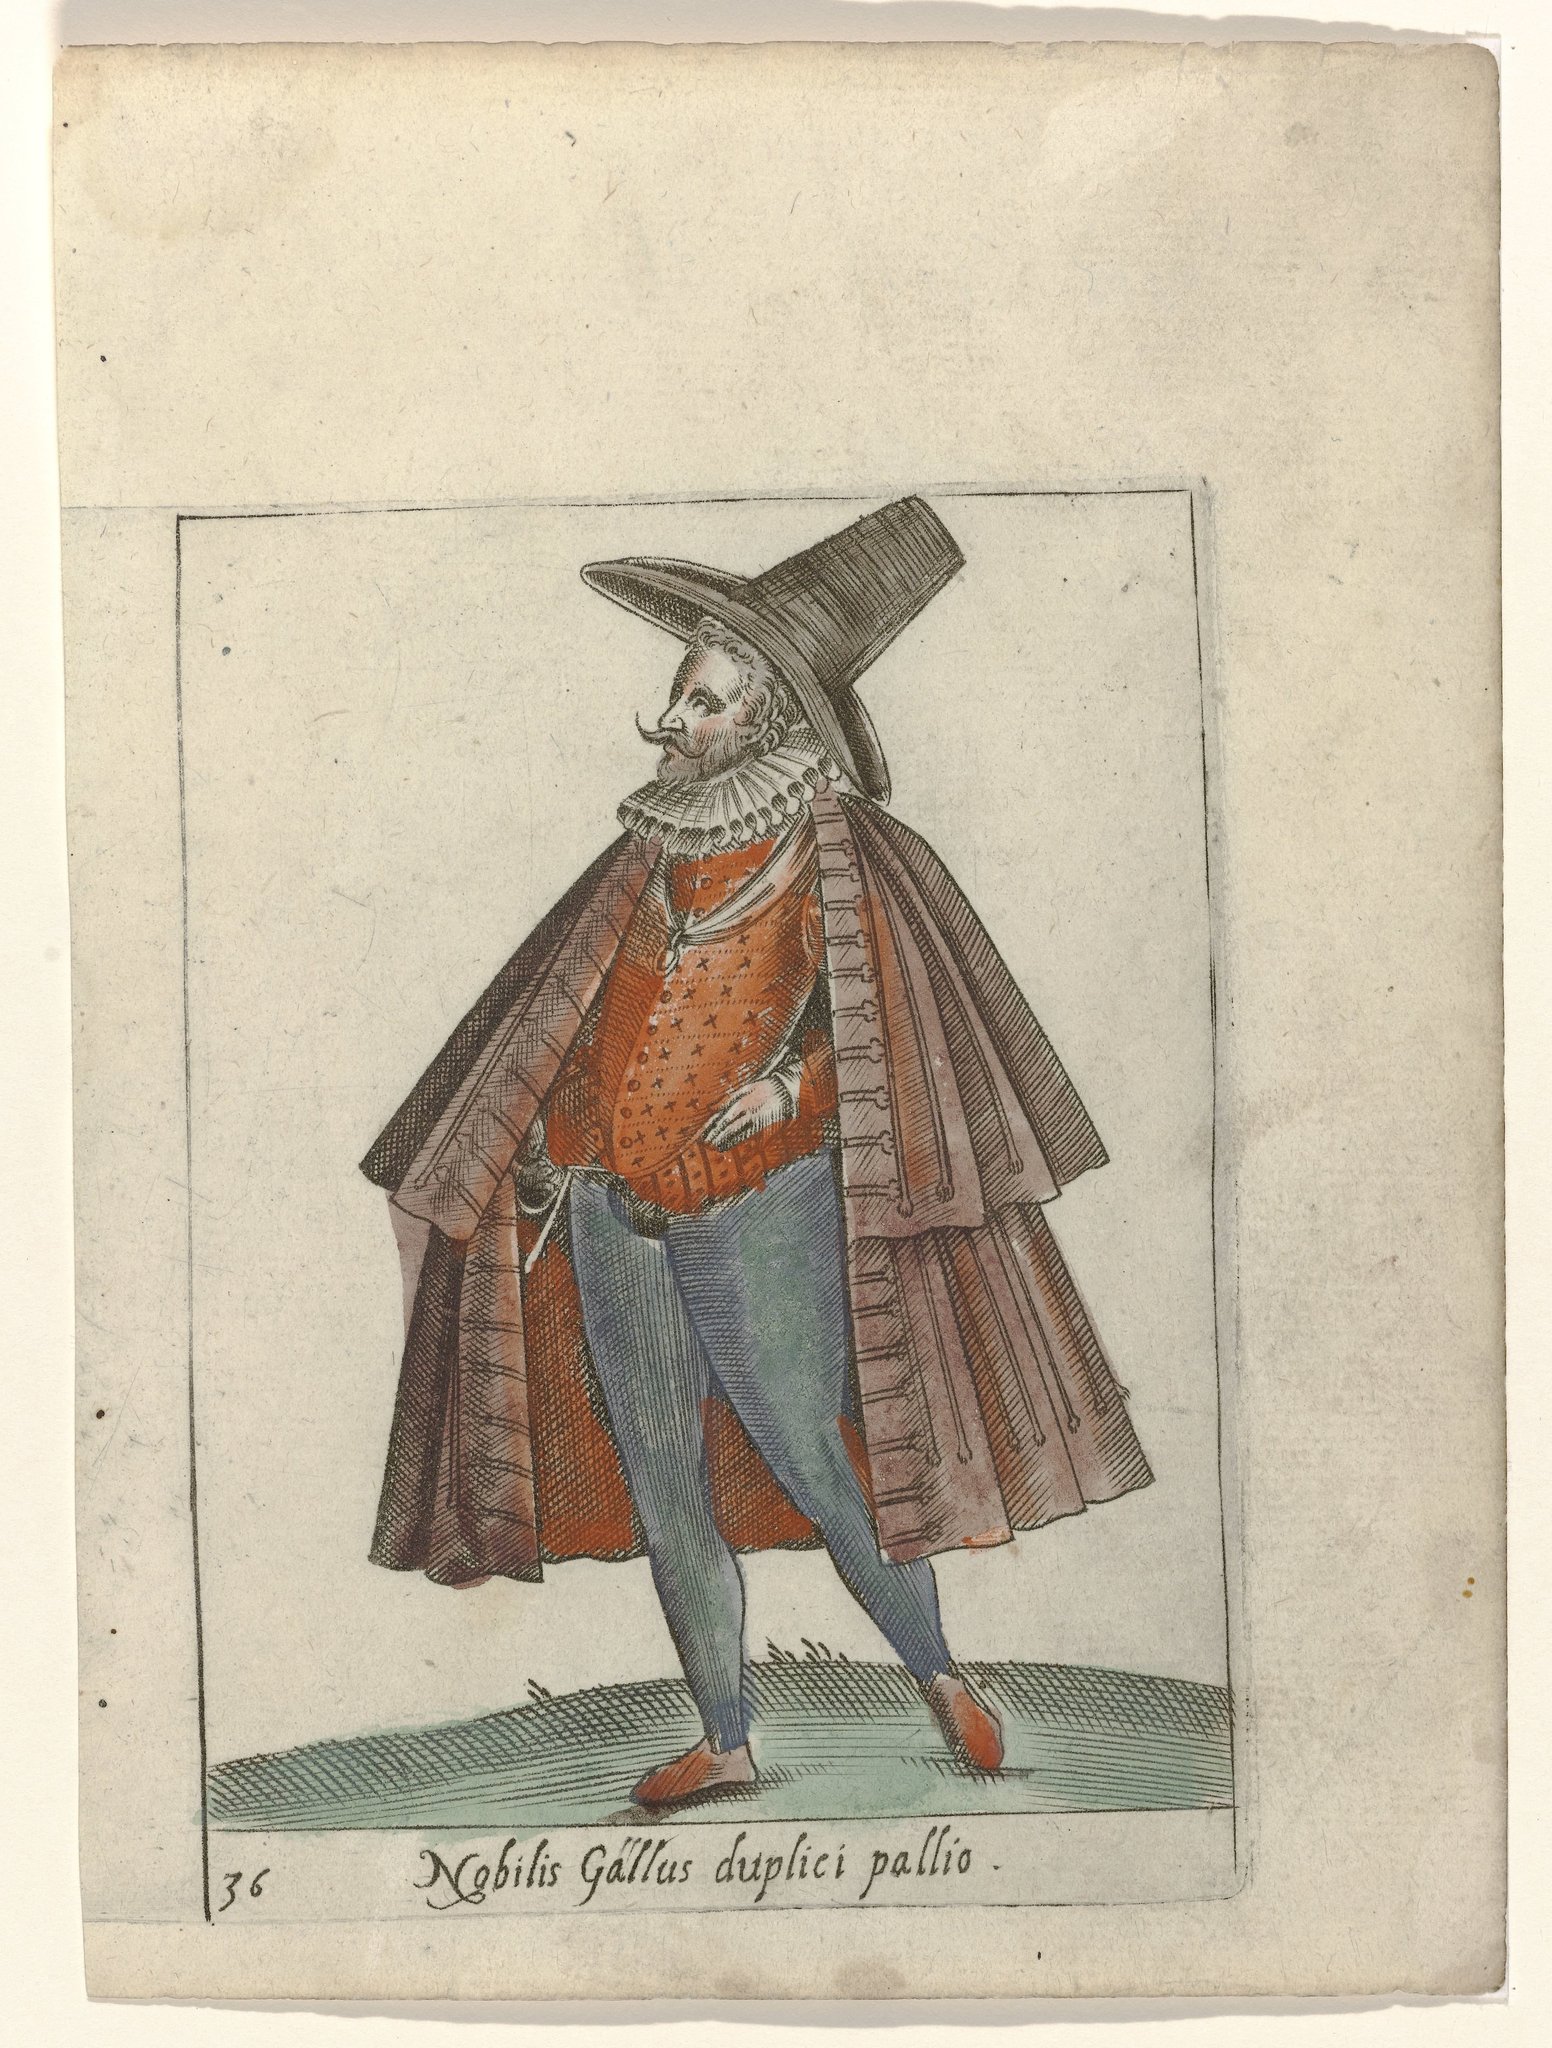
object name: print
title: Nobilis Gallus duplici pallio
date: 1594-1596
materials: paper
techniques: engraving, hand coloring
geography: padua